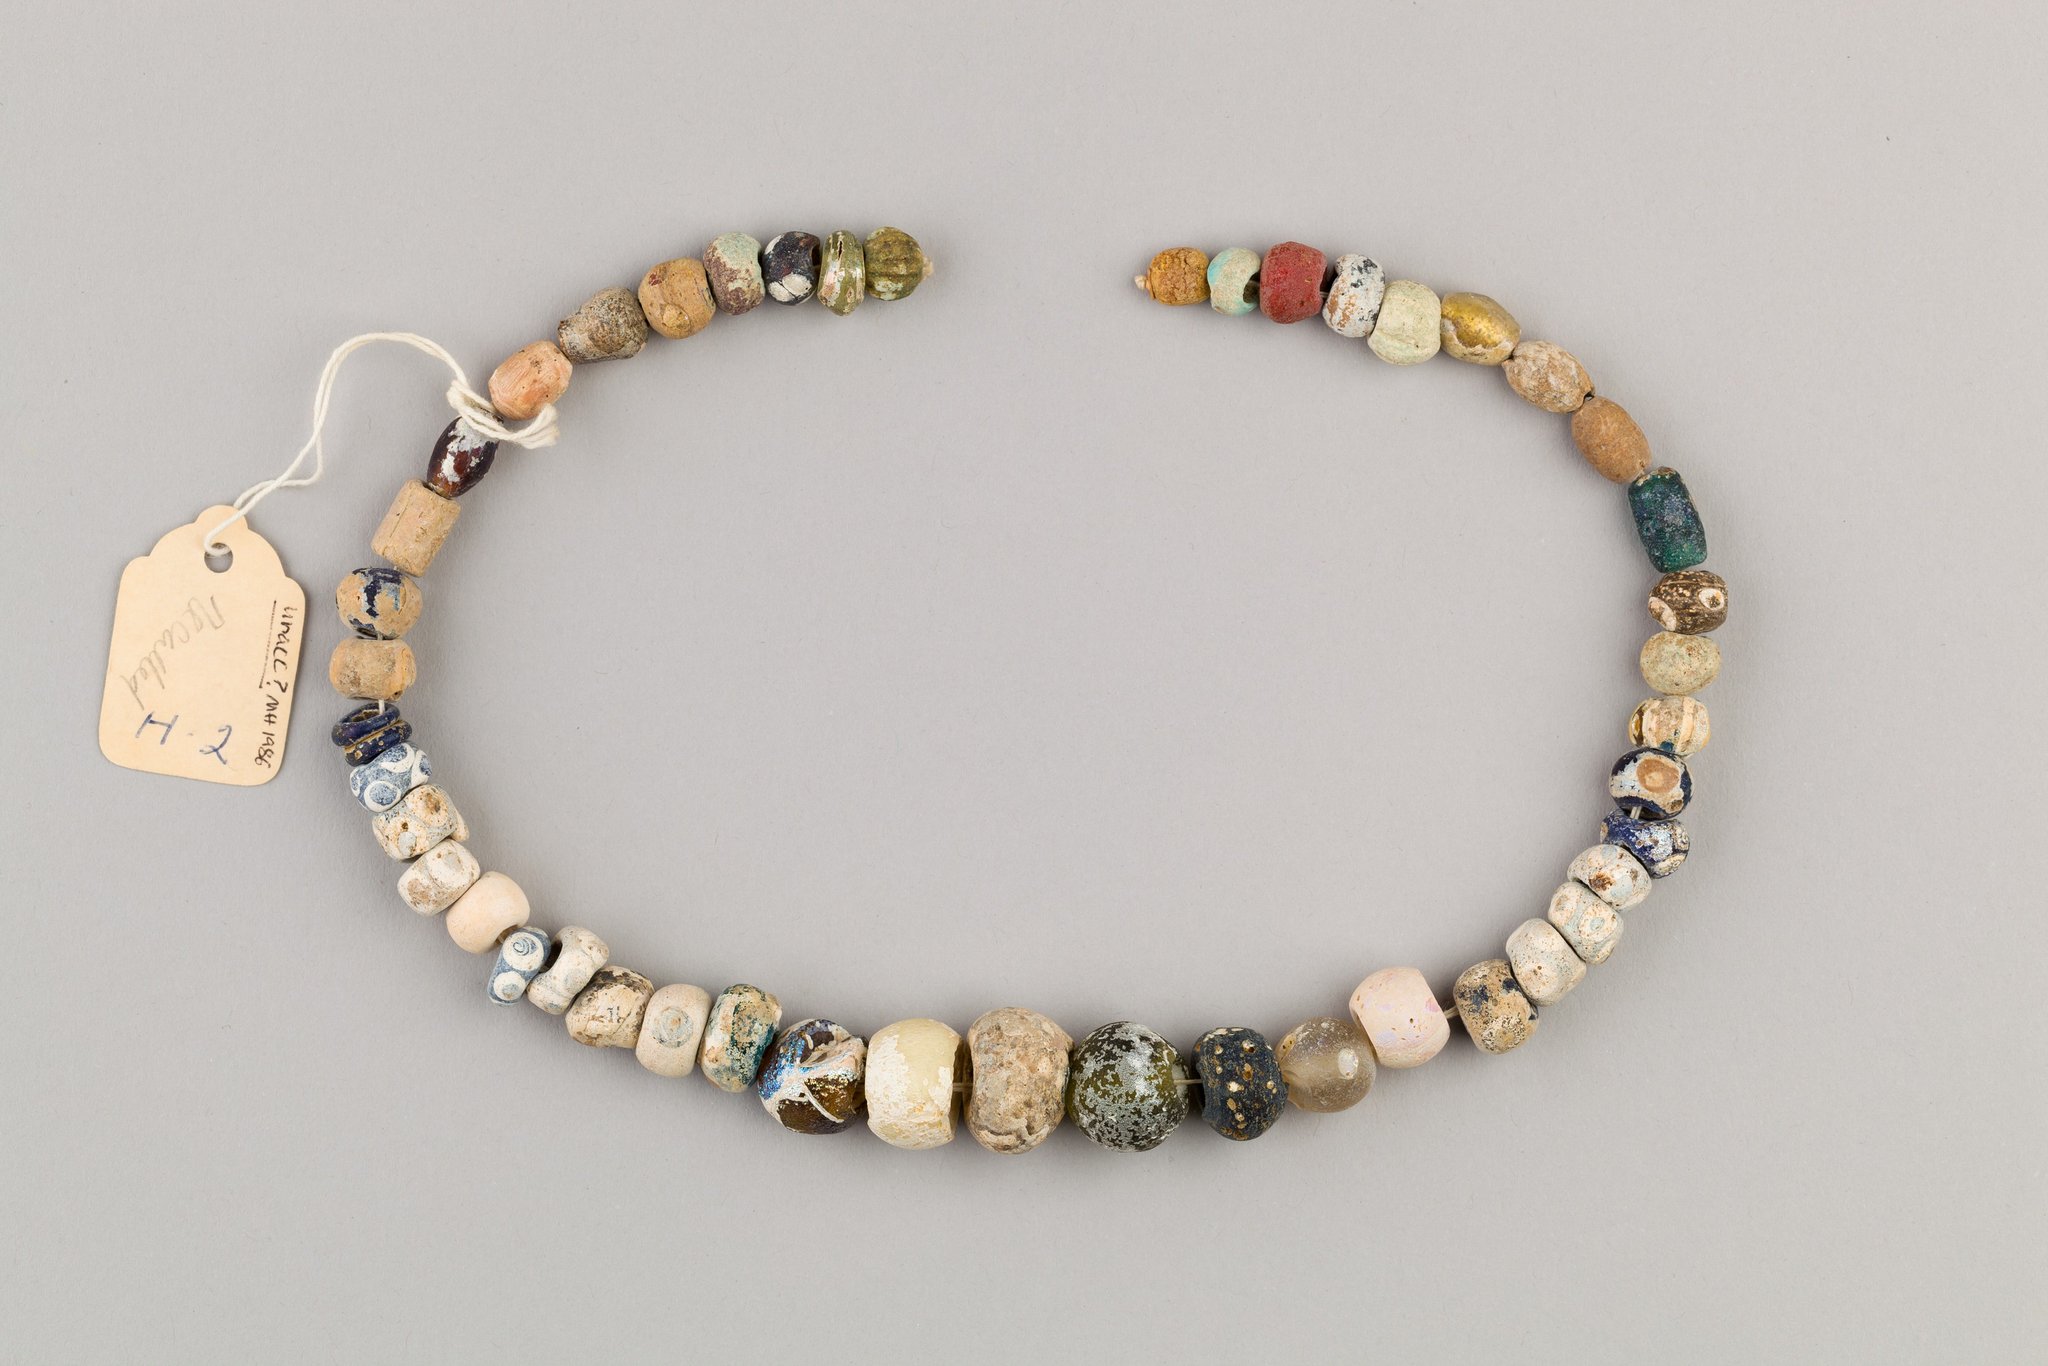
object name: bead, string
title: String of beads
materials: glass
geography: egypt